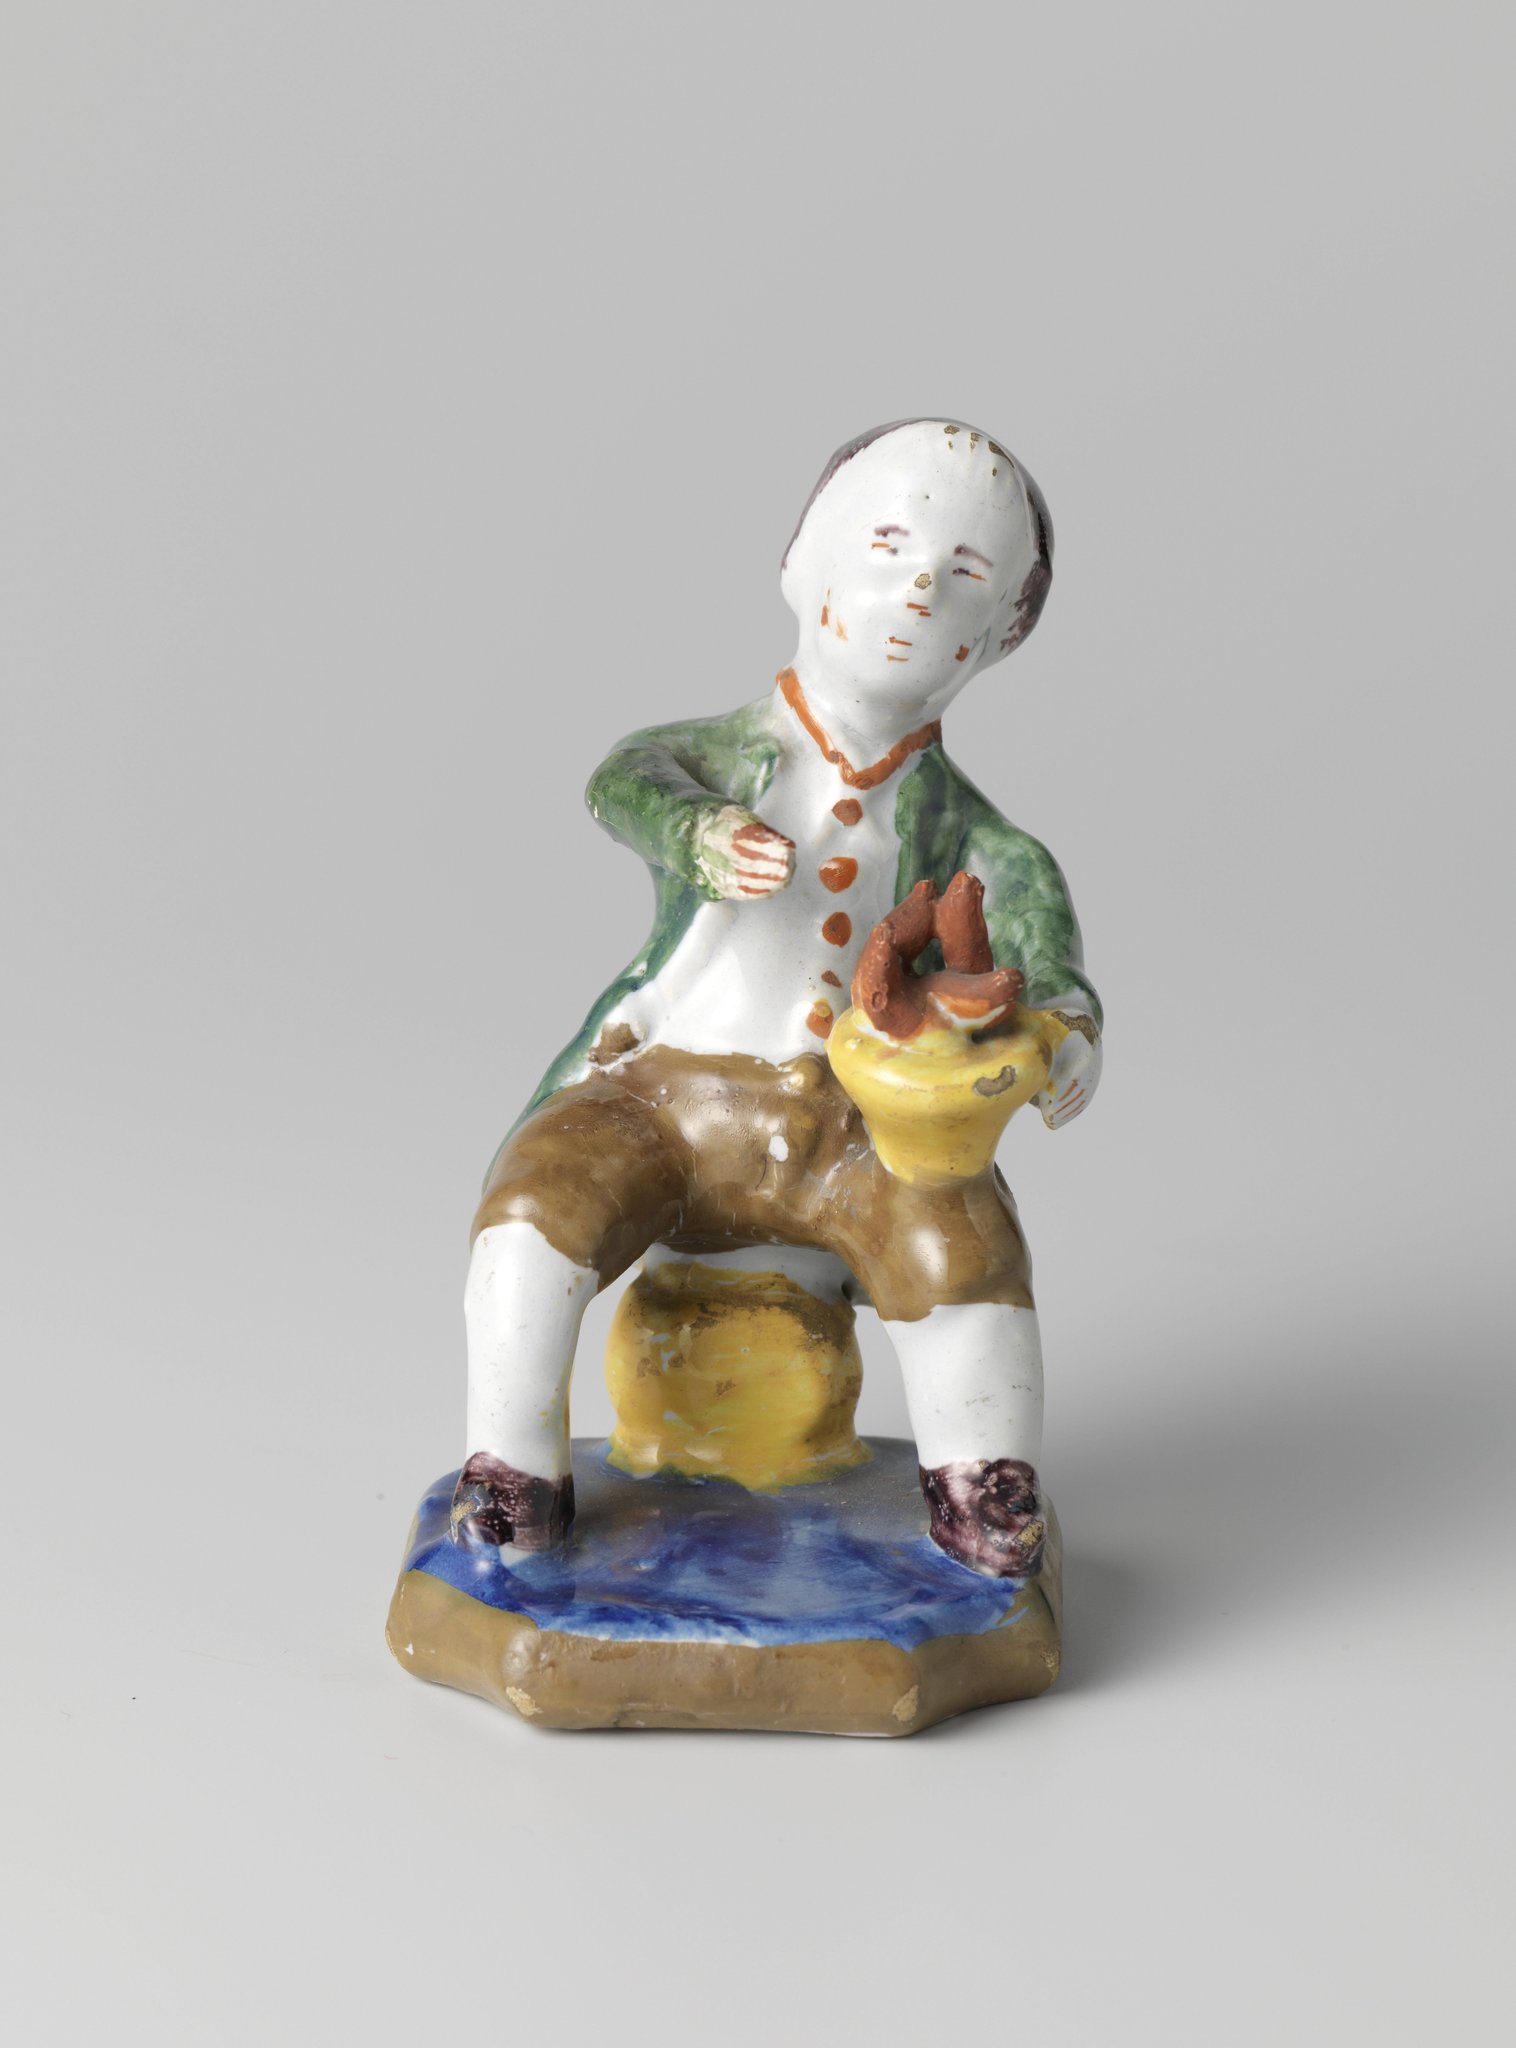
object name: figure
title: Man met vuurpot van faience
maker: Anonymous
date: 1750-1780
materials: faience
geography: delft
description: Man met vuurpot van faience. Veelkleurig beschilderd.